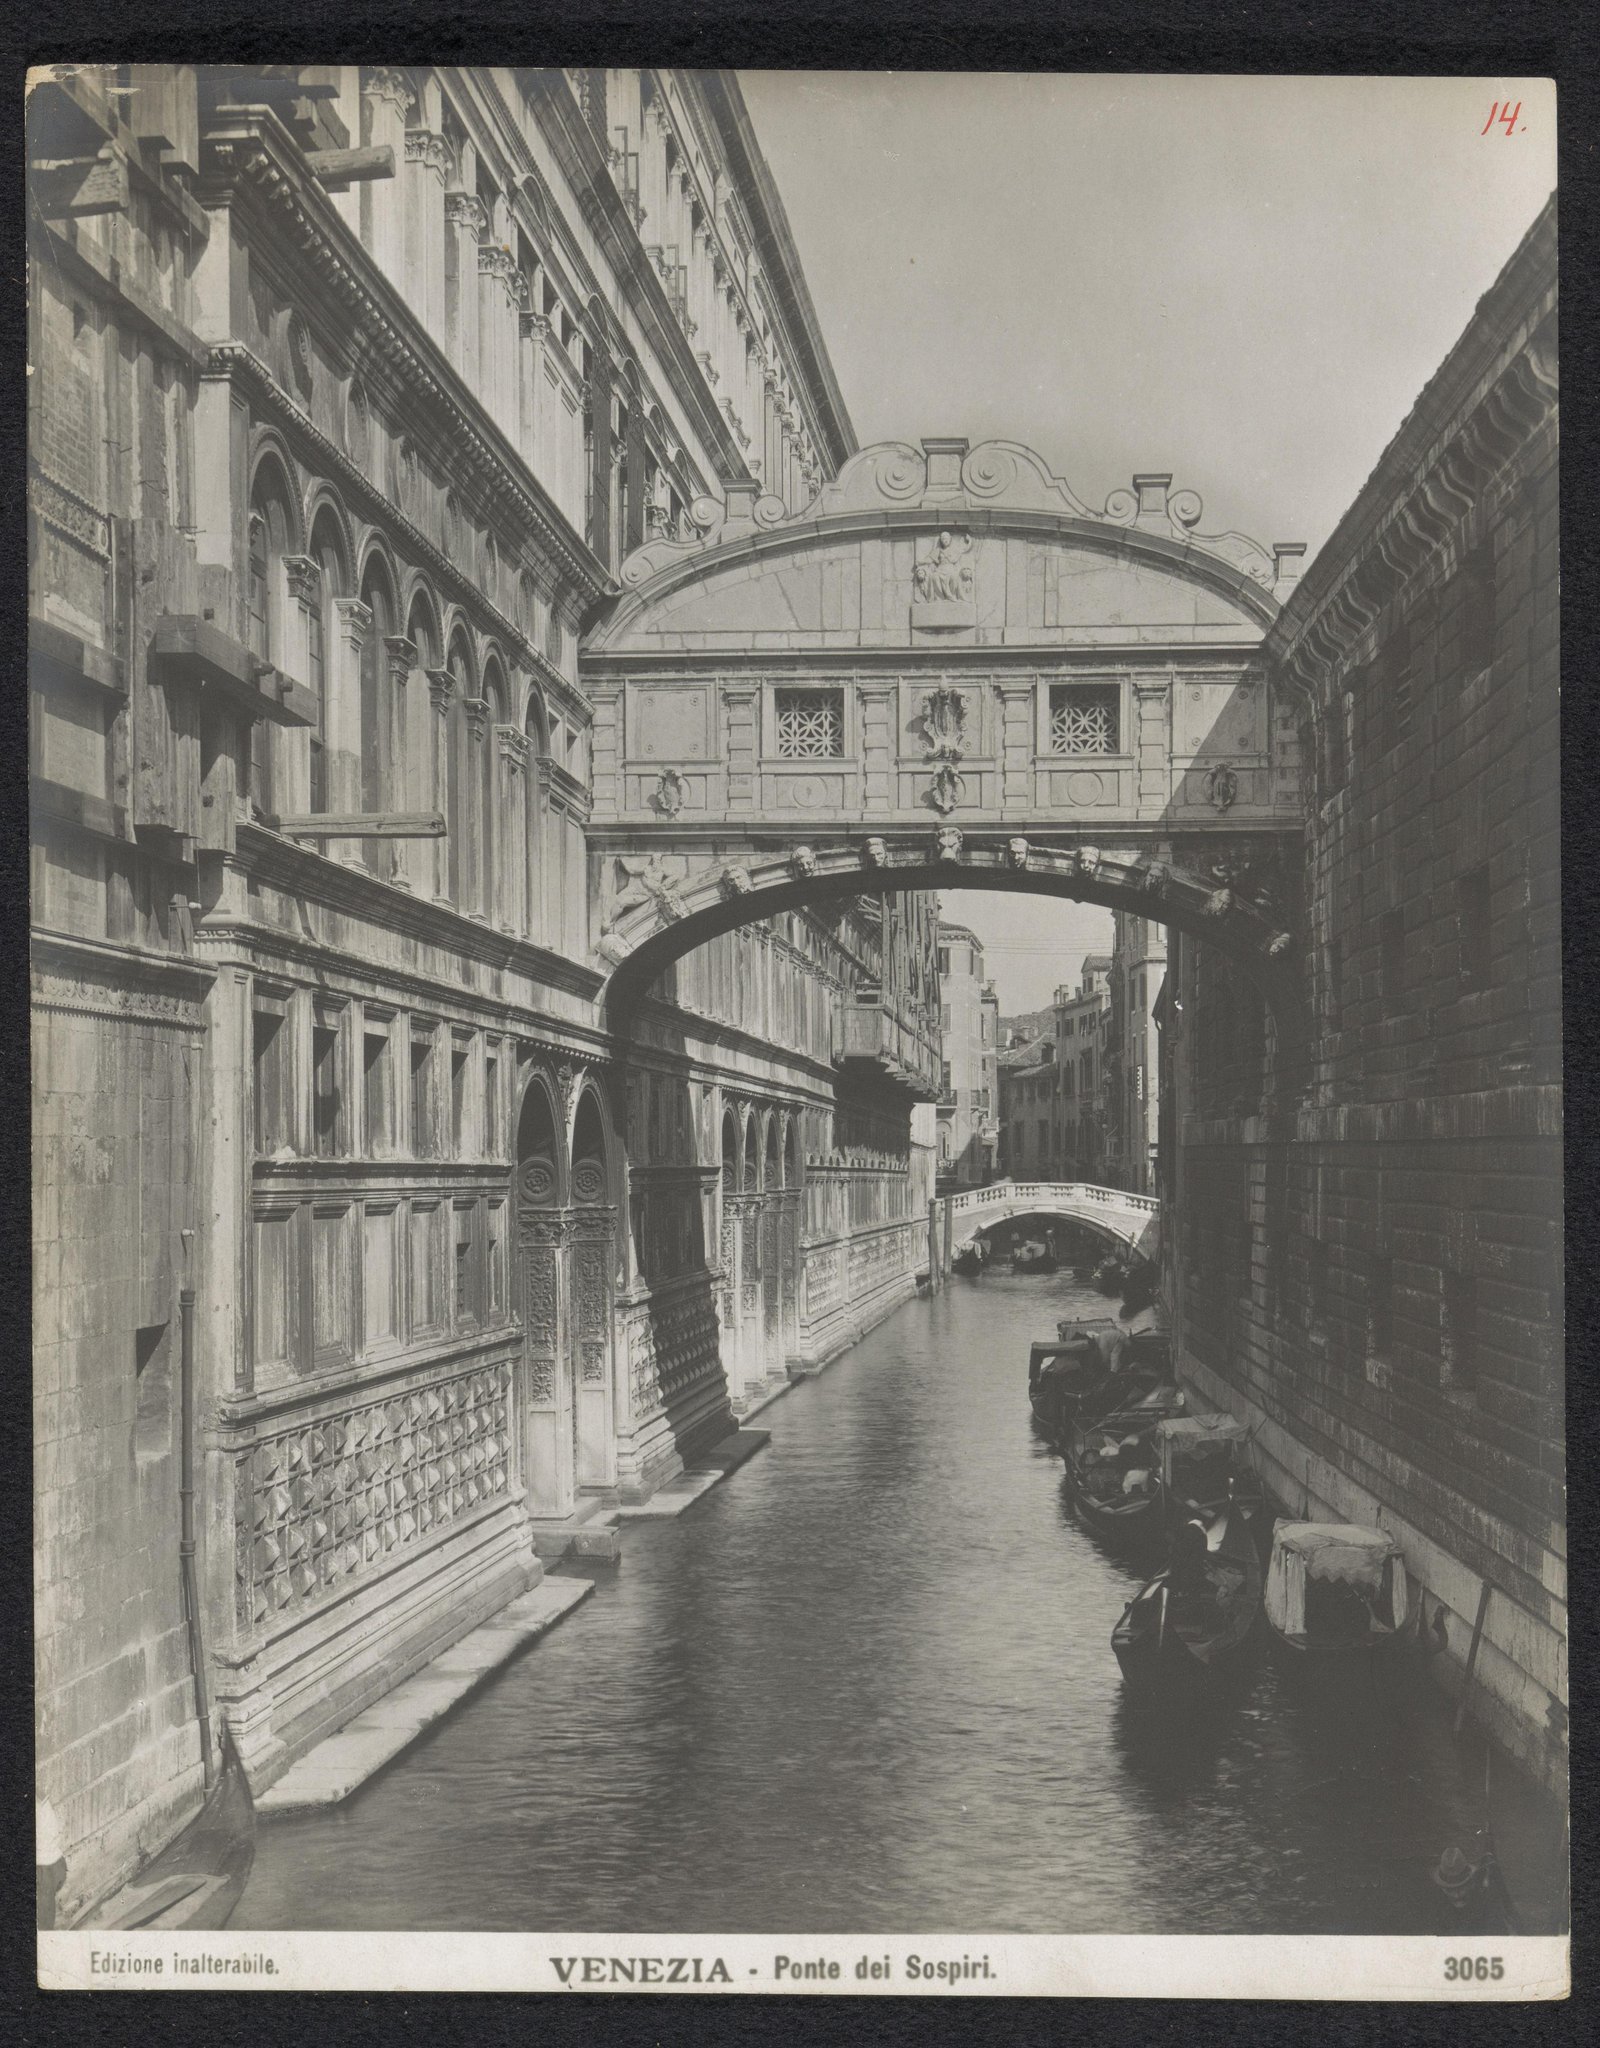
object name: photograph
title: Venezia - Ponte dei Sospiri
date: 1900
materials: cardboard, photographic support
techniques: gelatin silver print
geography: venice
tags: canal, bridge, gondola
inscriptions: number: ‘3065’, inscription: ‘Rijksnormaalschool voor Teekenonderwijzers Amsterdam’, number: ‘14.’